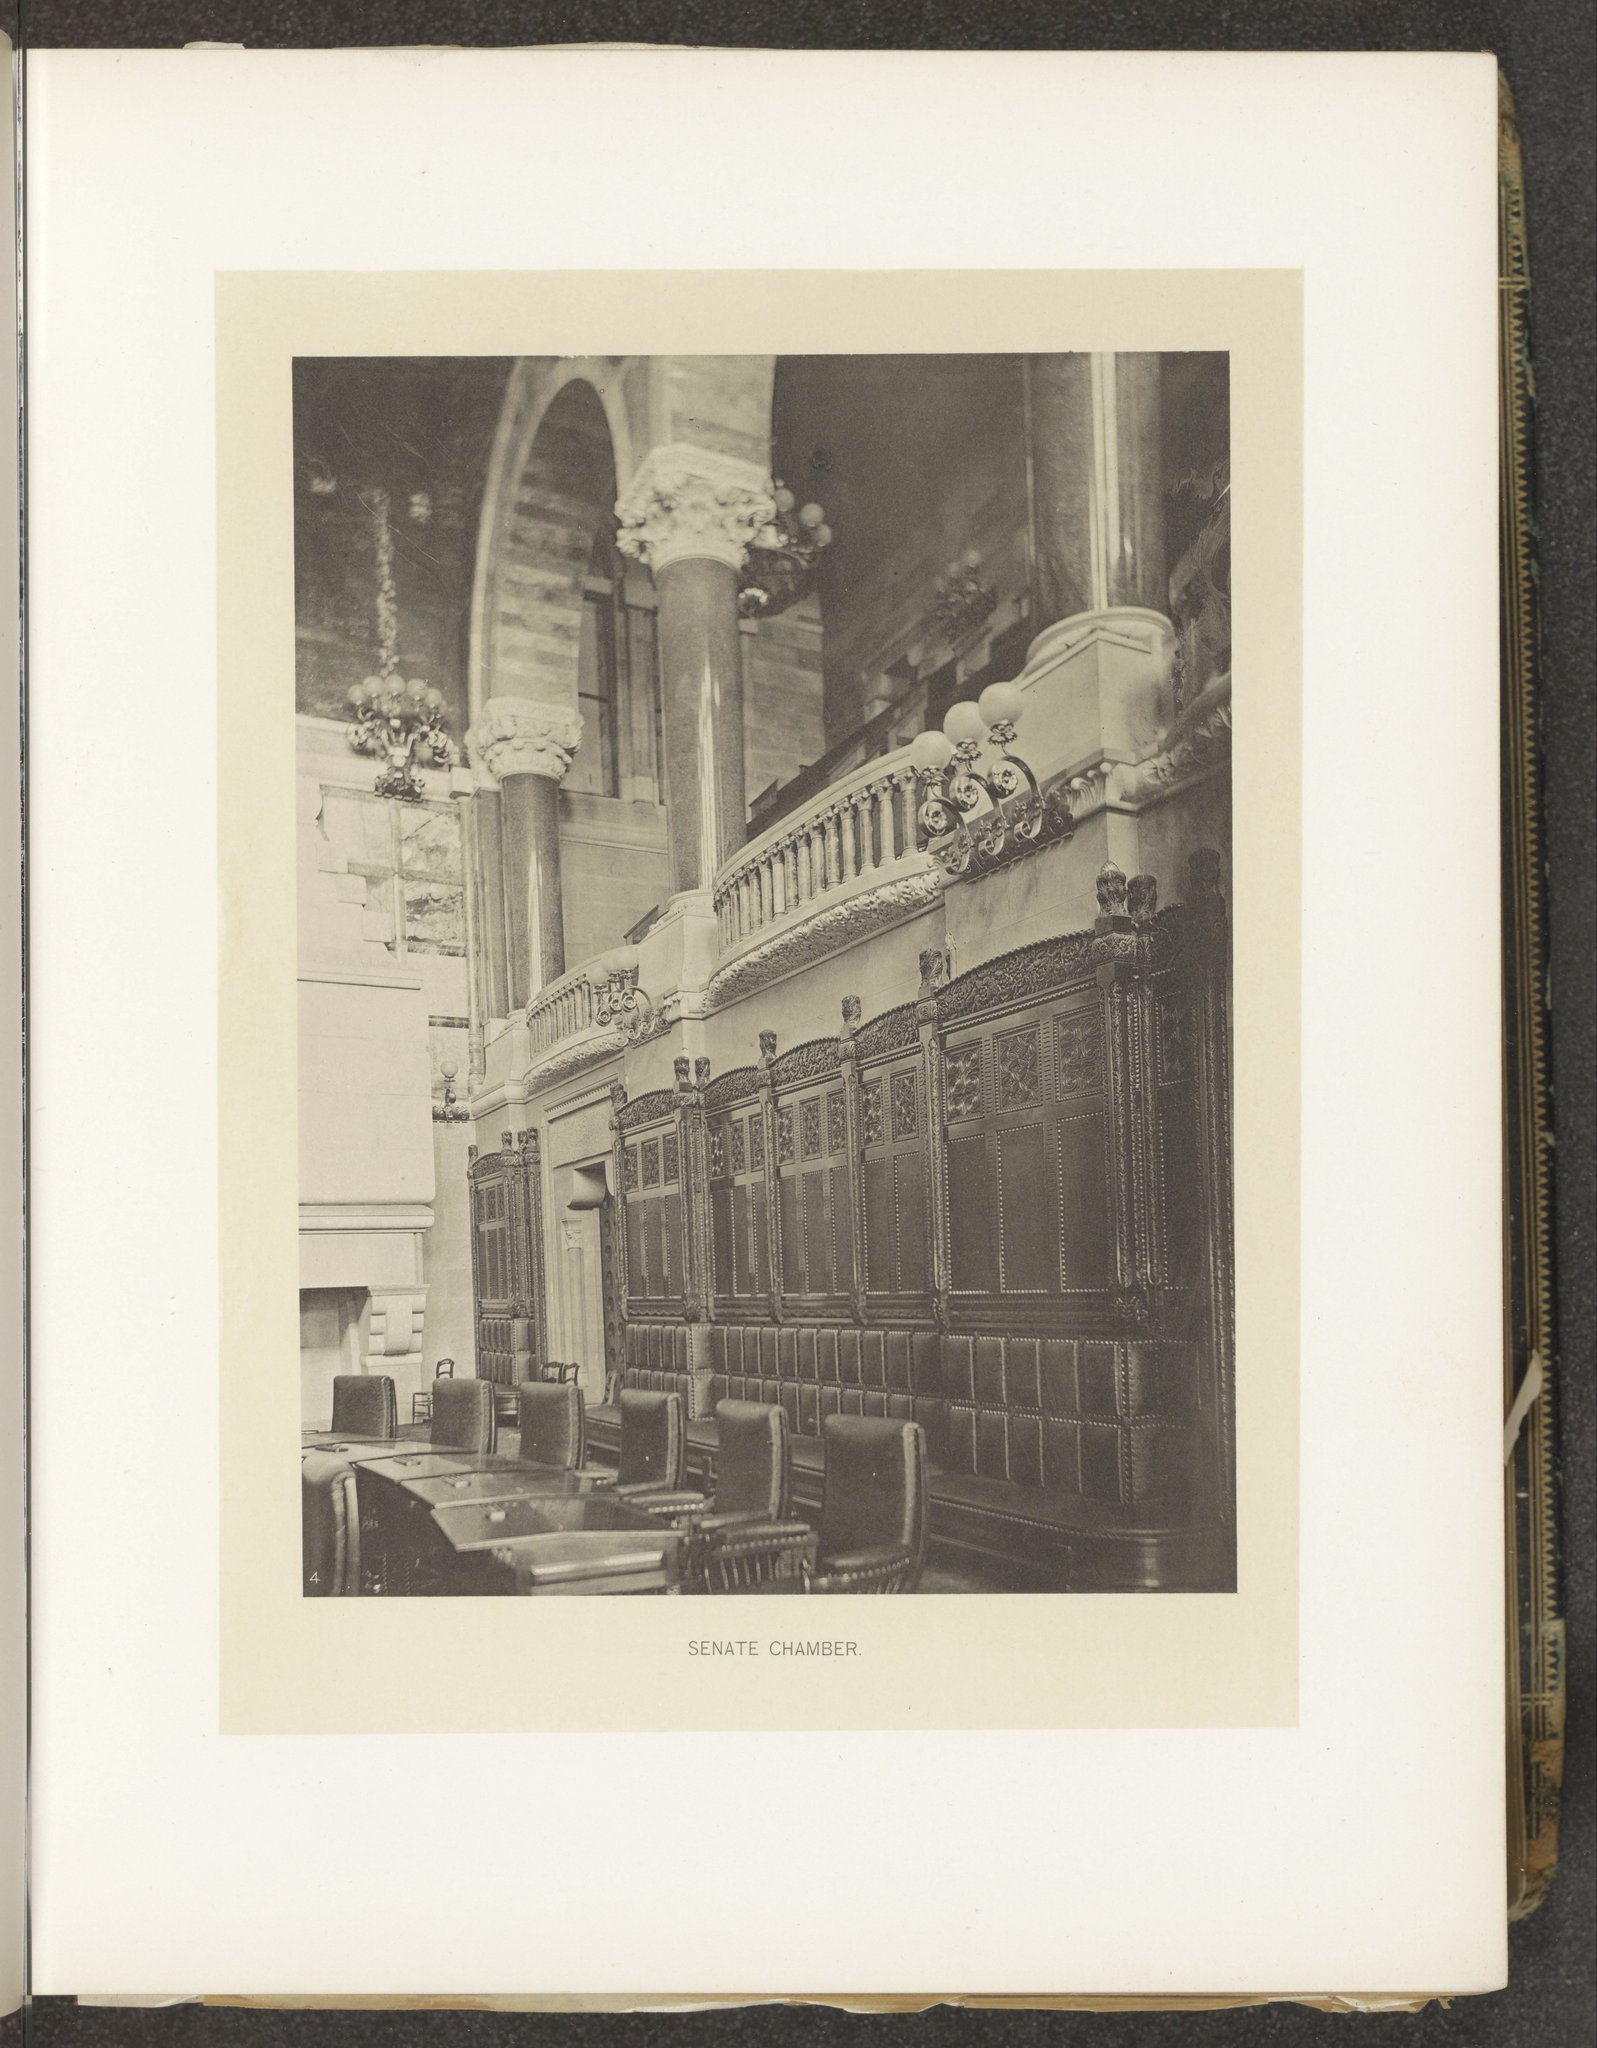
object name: page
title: Senate Chamber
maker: Anonymous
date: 1879-1882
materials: paper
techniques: photograph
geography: united states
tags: interior ~ representation of a building, upper house, senate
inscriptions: number: ‘4’